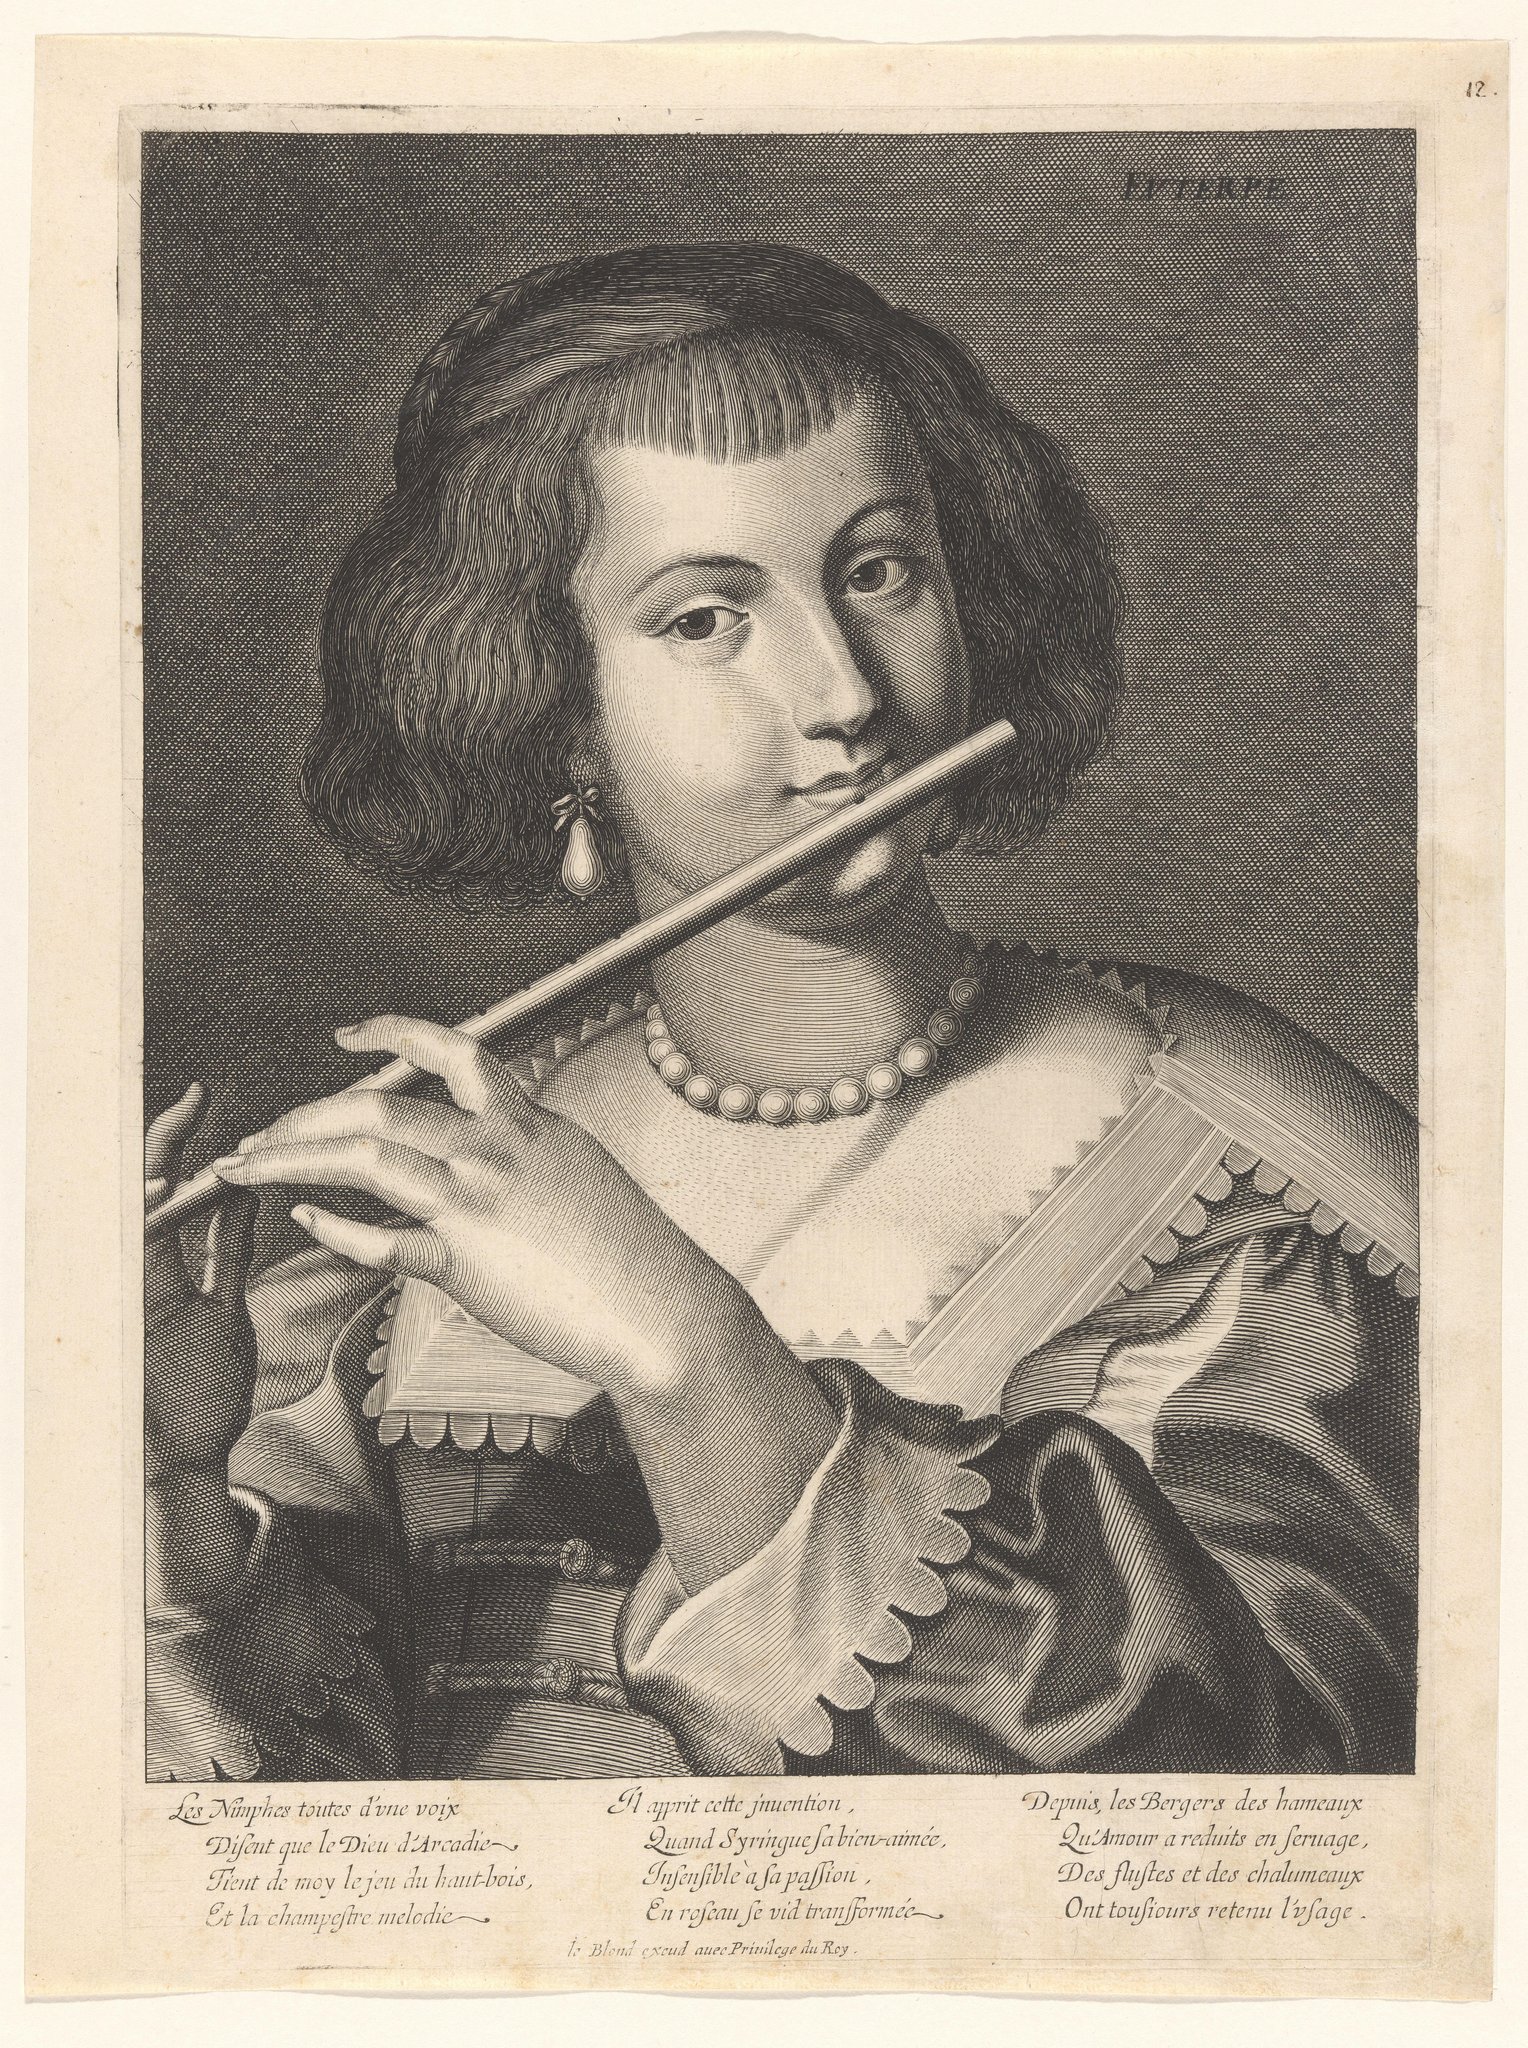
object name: print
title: Apollo and the Nine Muses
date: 1630-1635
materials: paper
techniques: engraving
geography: france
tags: one person playing wind instrument, transverse flute, euterpe (one of the muses); 'euterpe' (ripa)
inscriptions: collector's mark: Lugt 2760, collector's mark: Lugt 2228, number: ‘12’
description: While there are numerous depictions of Apollo and the nine muses, these ones are exceptional. In Greek mythology, Apollo is the god of music and harmony and his sisters, the muses, are the goddesses of art and science and symbols of inspiration. Le Blond portrayed each of them separately, making music. Dressed and coiffed according to the latest Parisian fashion around 1630, they have thus become contemporary.